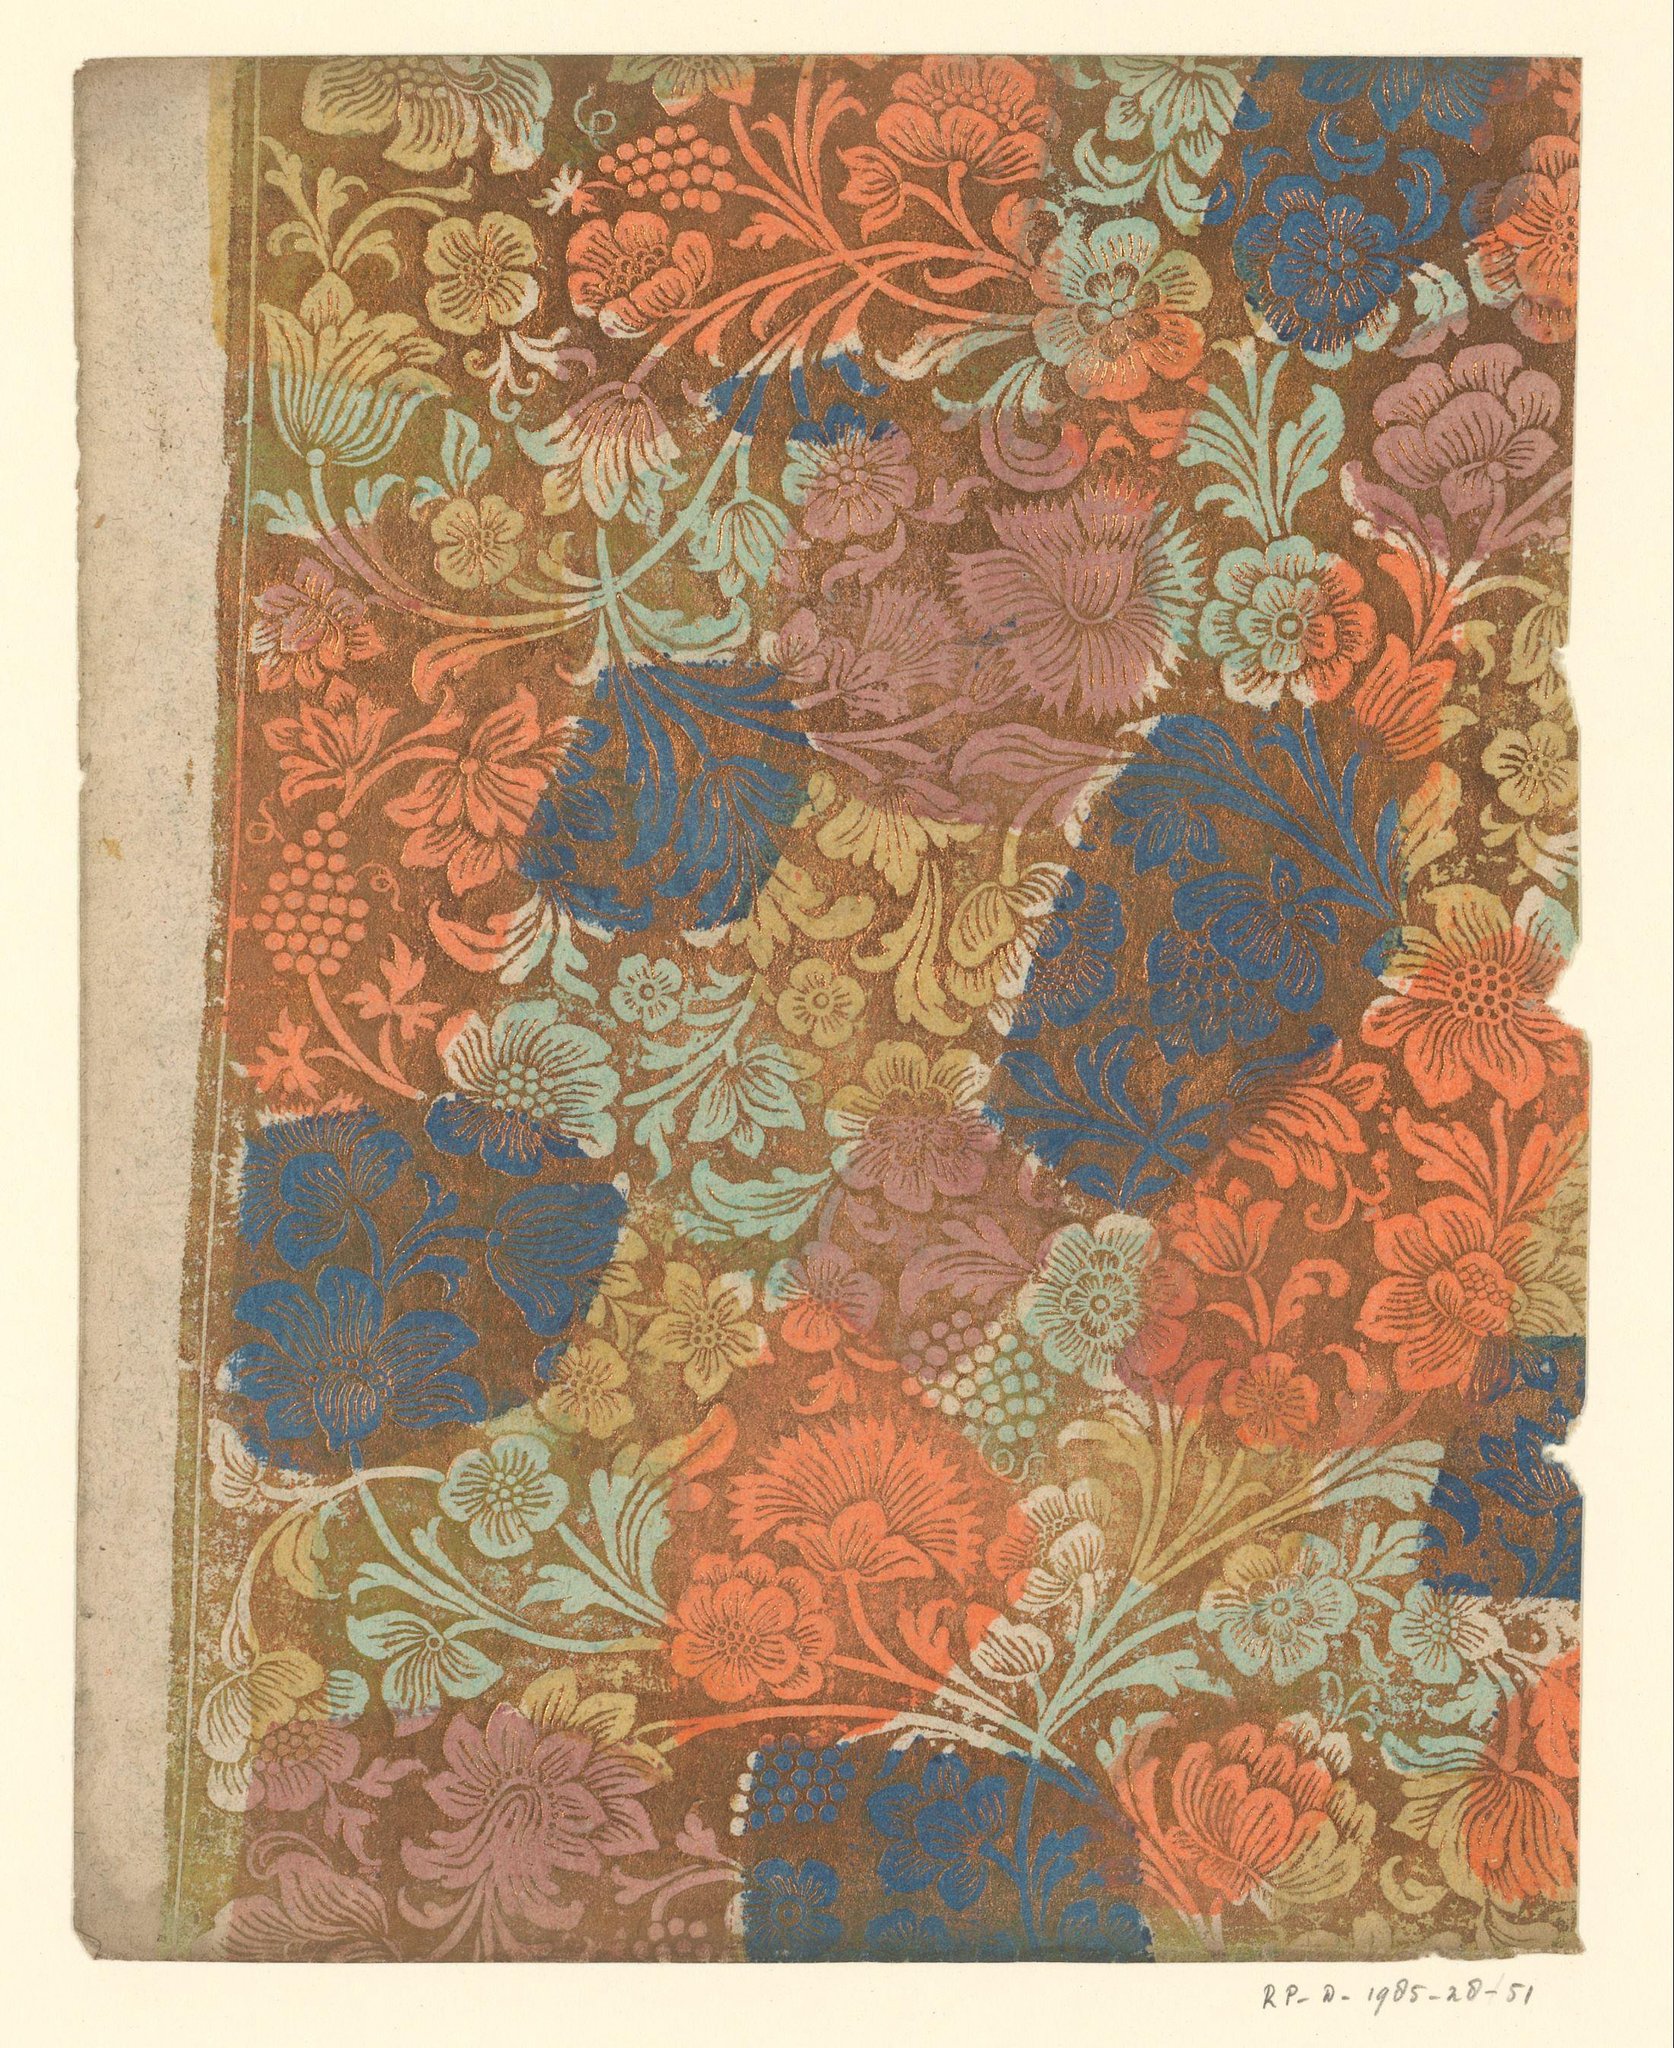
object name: brocade paper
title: Blad met bloemen en vruchten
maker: Anonymous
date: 1700-1850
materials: gold leaf, paper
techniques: relief print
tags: ornament derived from plant forms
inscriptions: collector's mark: Lugt 2760, collector's mark: Lugt 2228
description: Blad met bloemen en vruchten. Helft van een omslag.